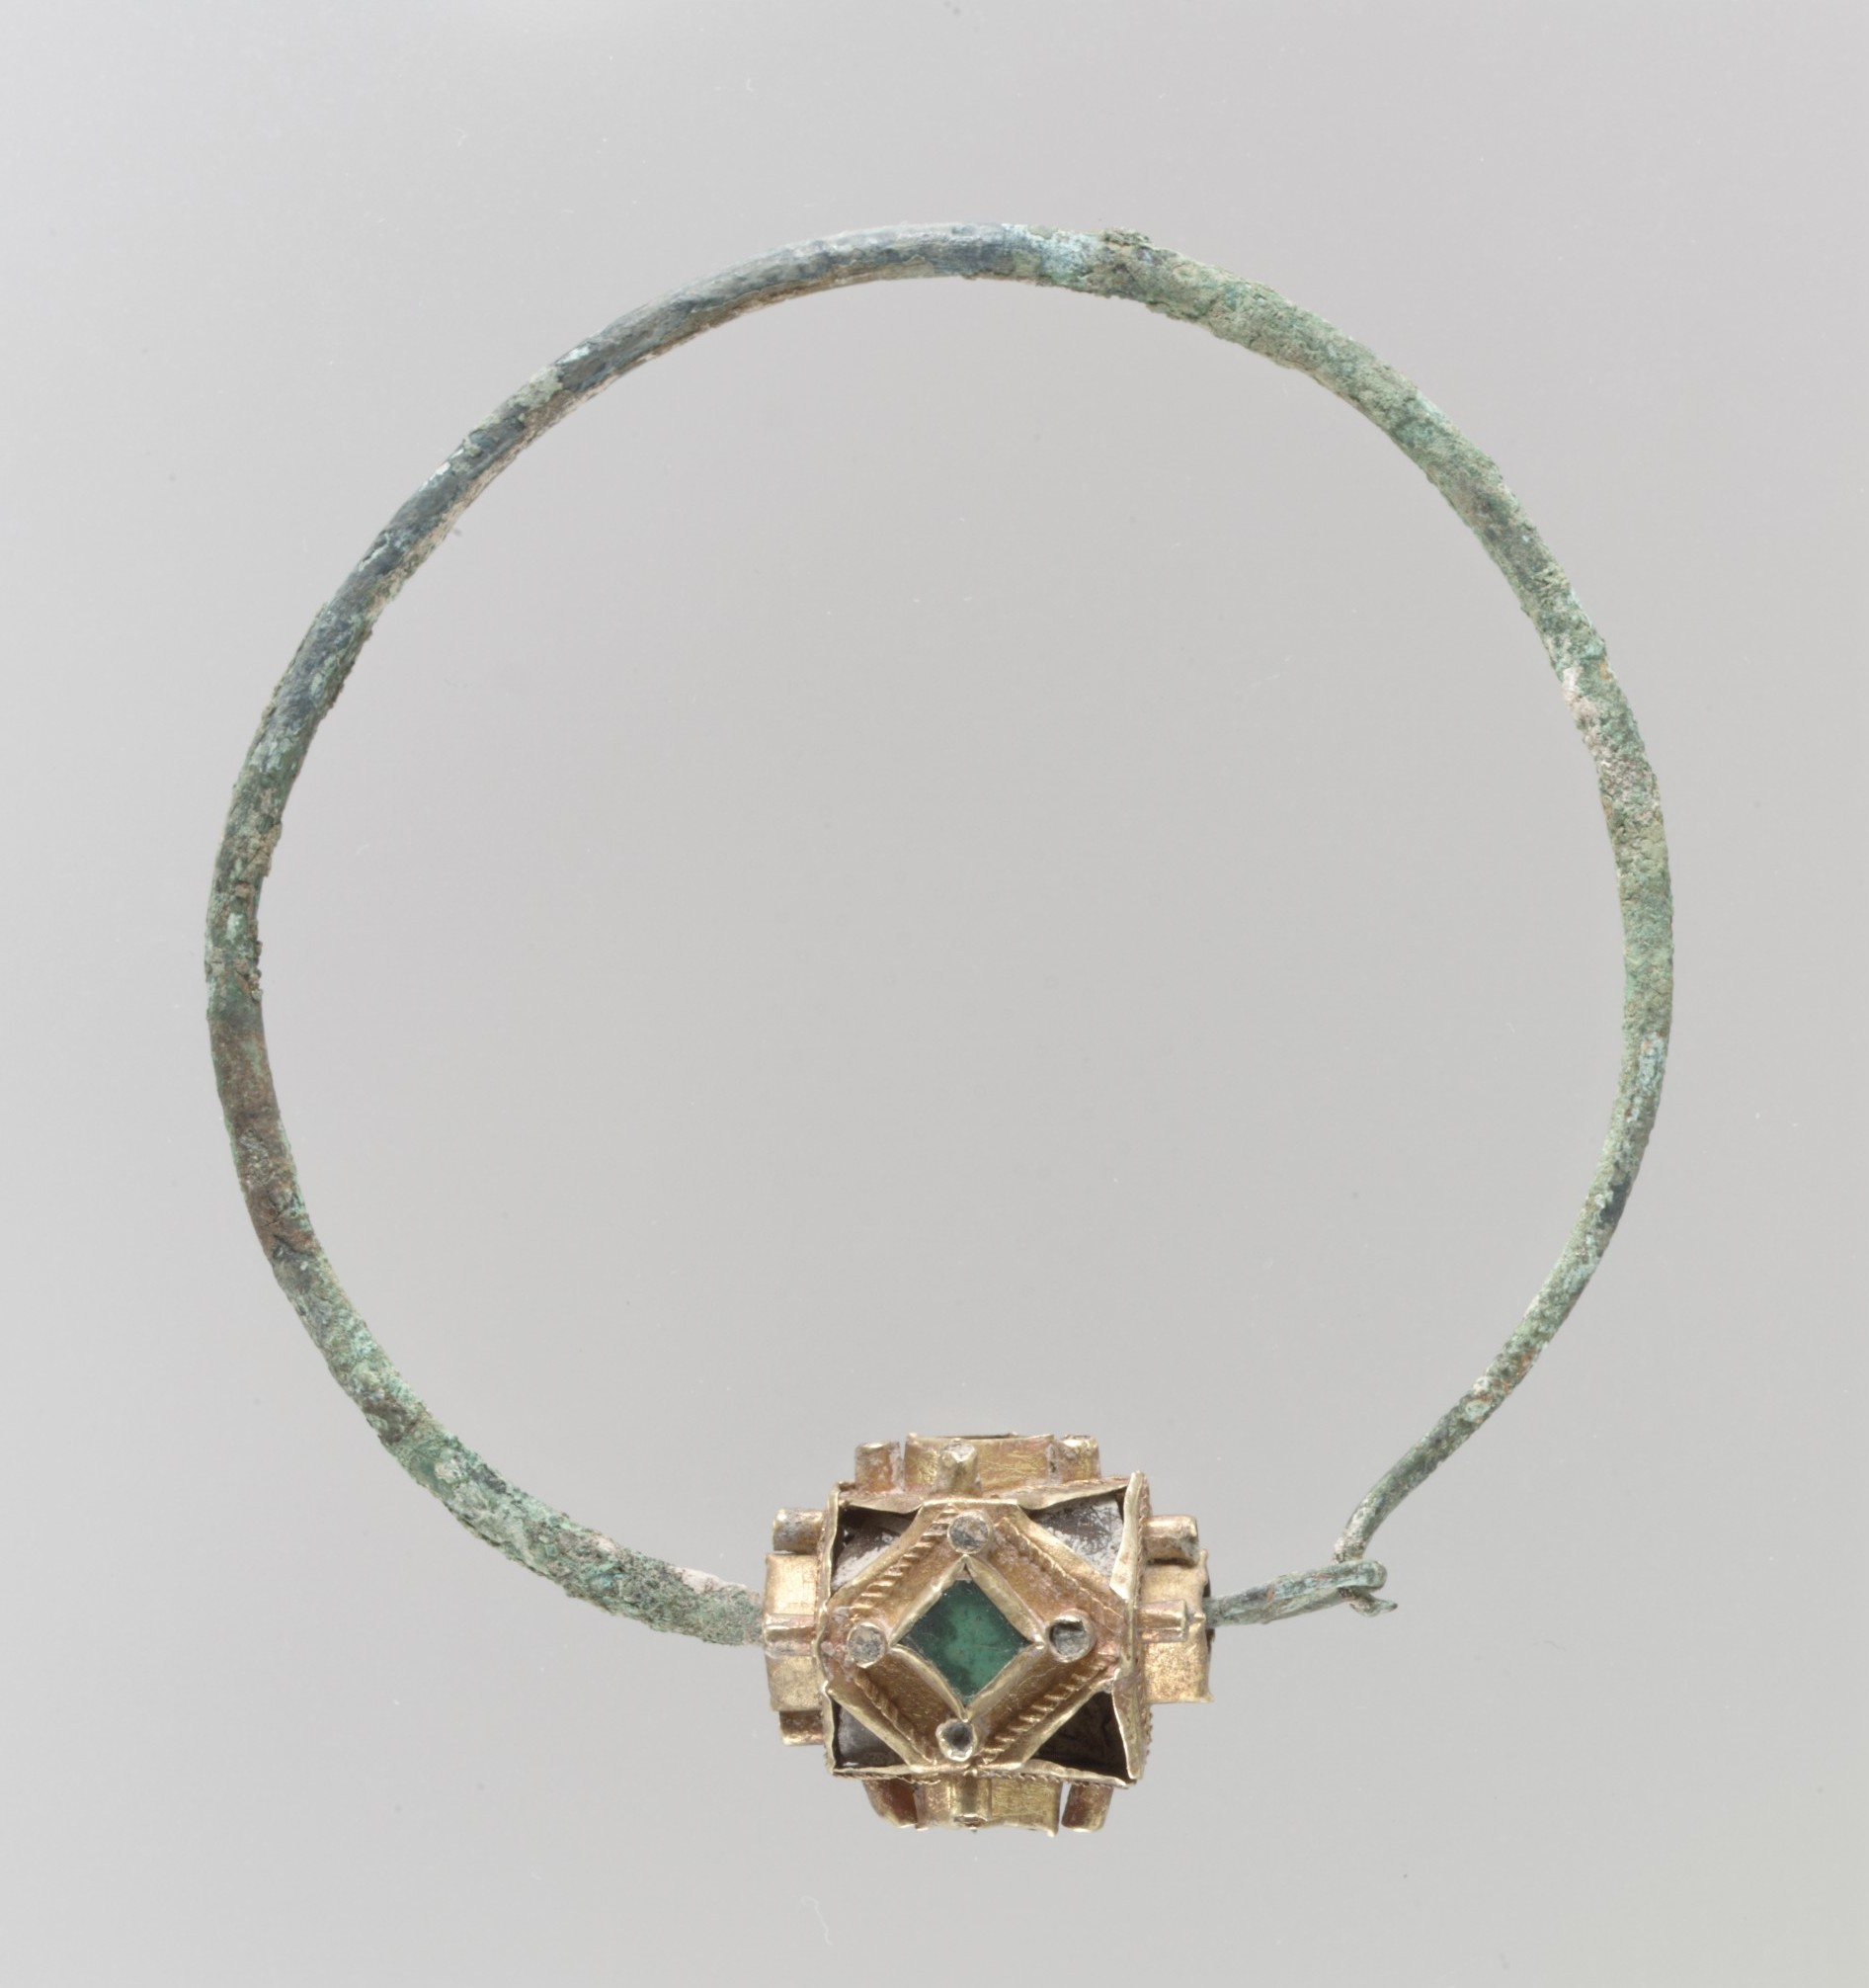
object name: earring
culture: frankish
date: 501-700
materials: copper alloy, glass, gold, pearl, silver